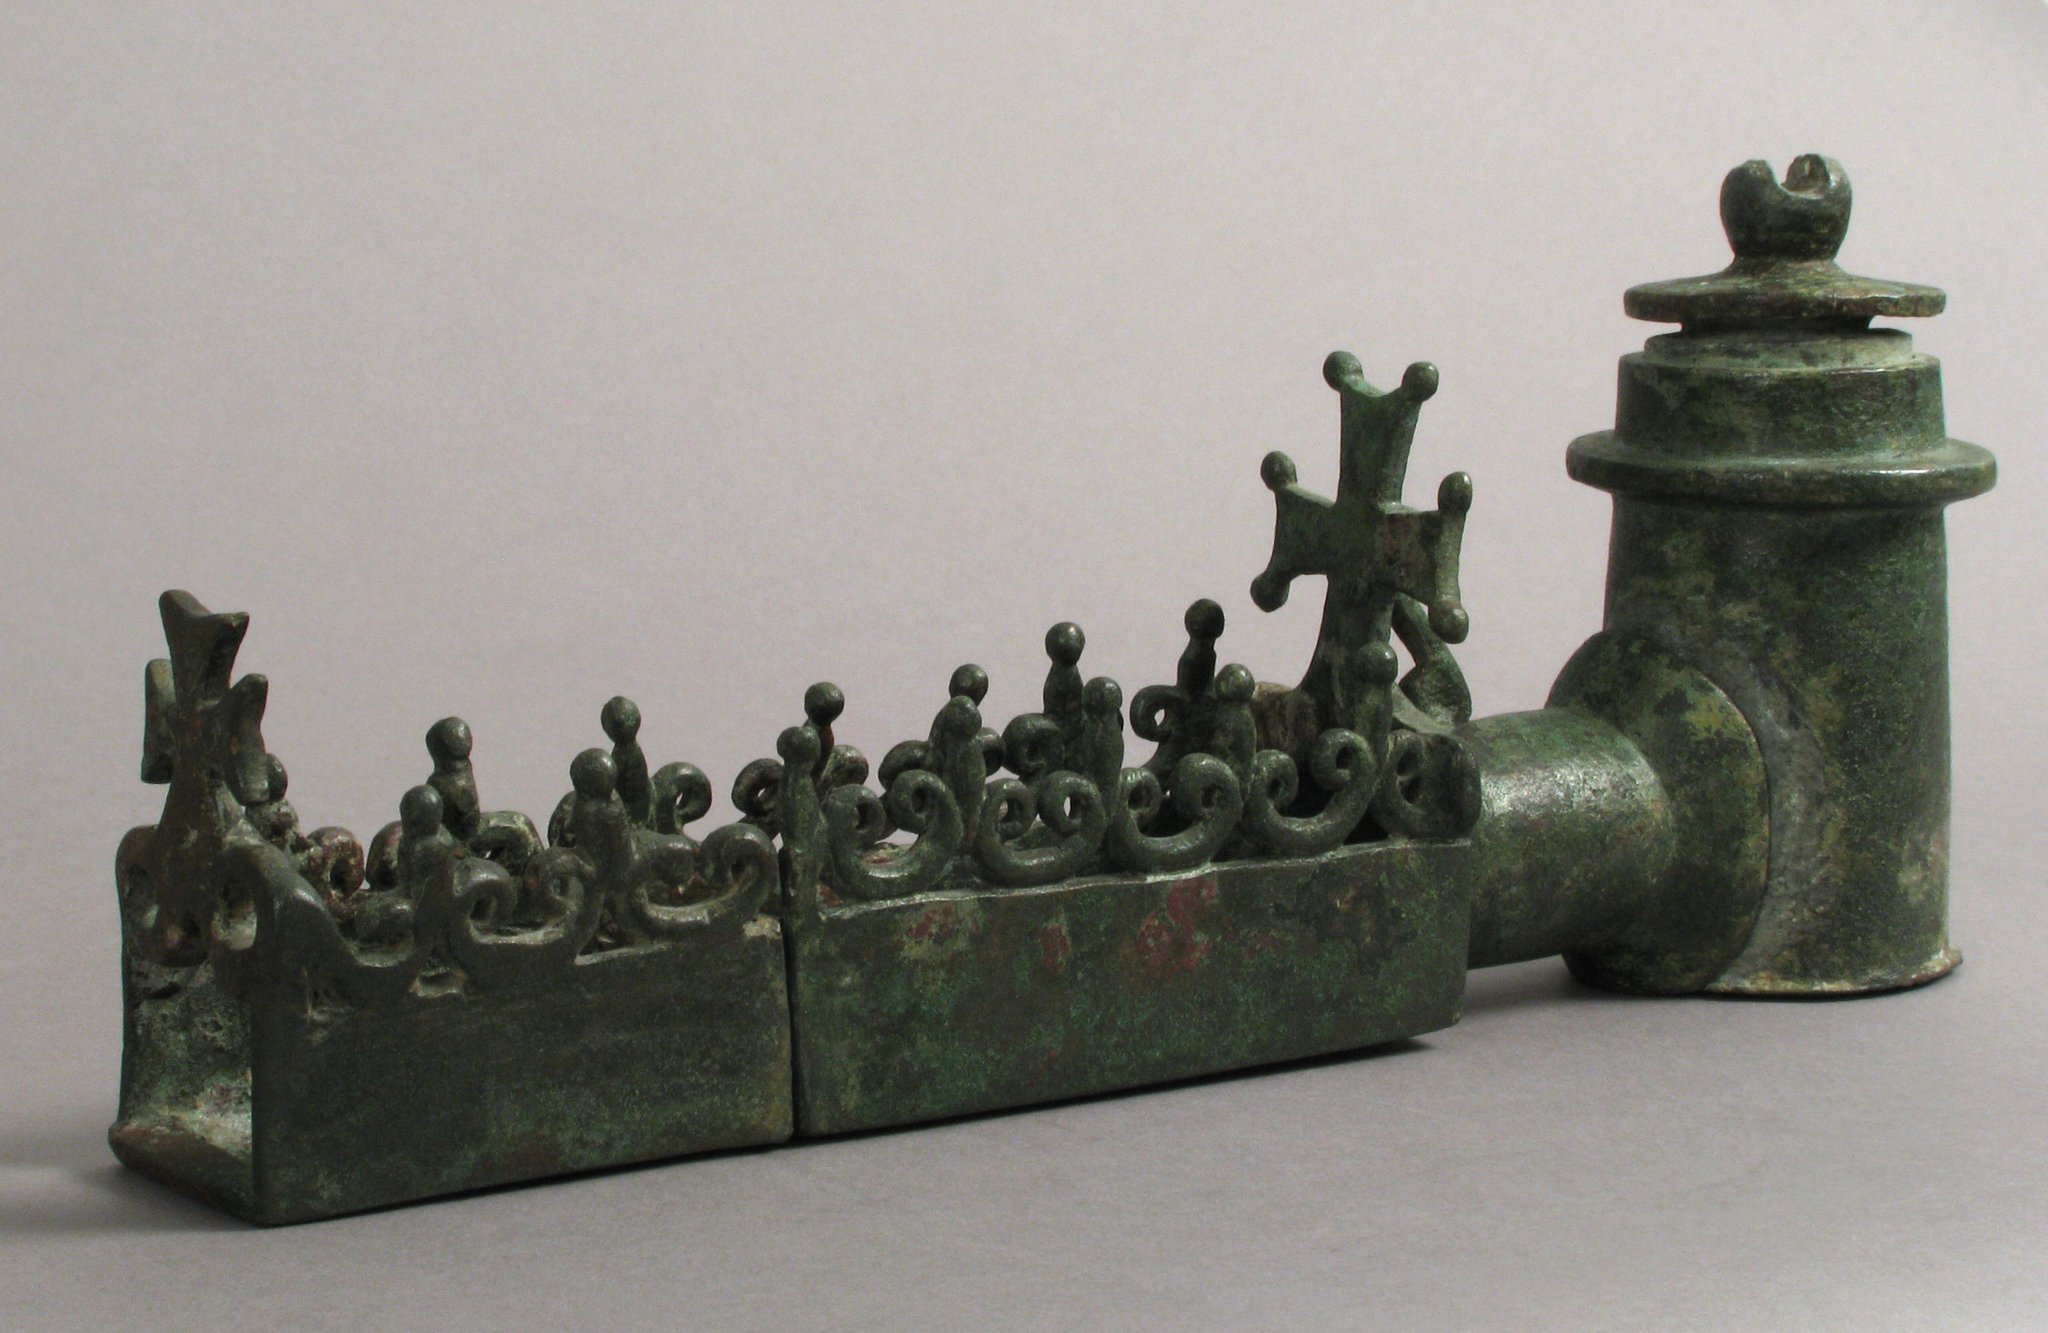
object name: faucet and conduit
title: Copper-Alloy Faucet and Conduit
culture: byzantine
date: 501-700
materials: copper alloy